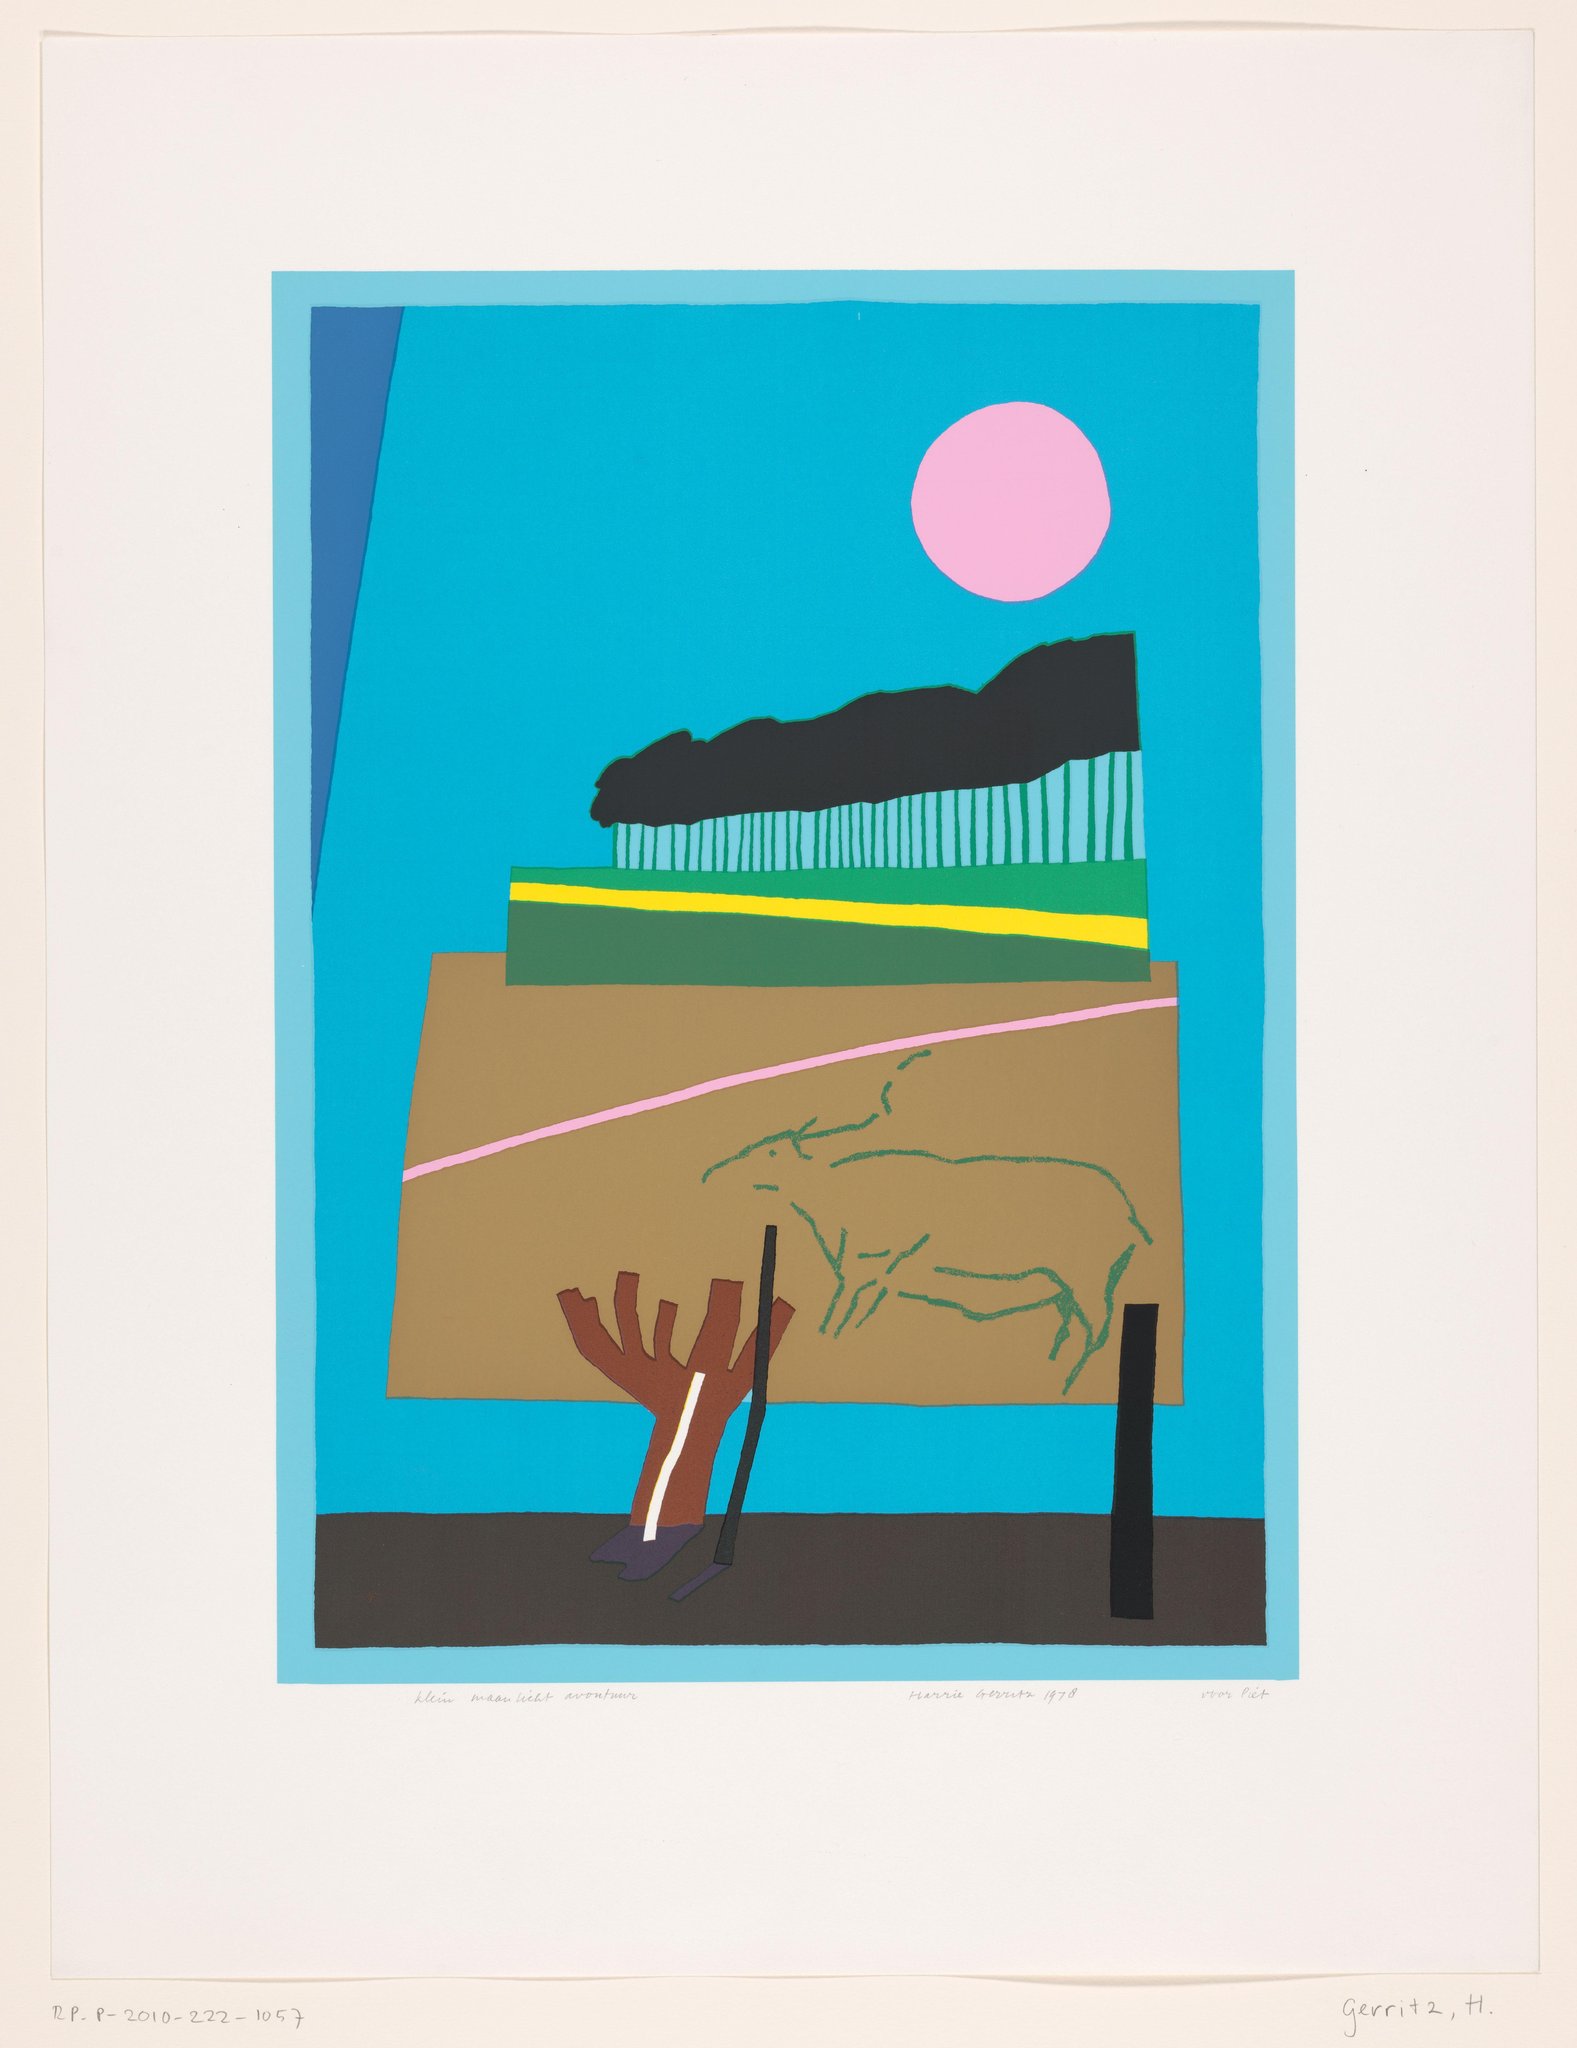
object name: print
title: Klein maanlicht avontuur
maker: harrie a. gerritz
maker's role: draughtsman, painter, print maker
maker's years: 1940-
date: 1978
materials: paper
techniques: screen printing in color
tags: trees, bull, landscapes in the temperate zone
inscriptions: inscription: ‘Shirley’, dedication: ‘voor Piet’, collector's mark: Lugt 2228